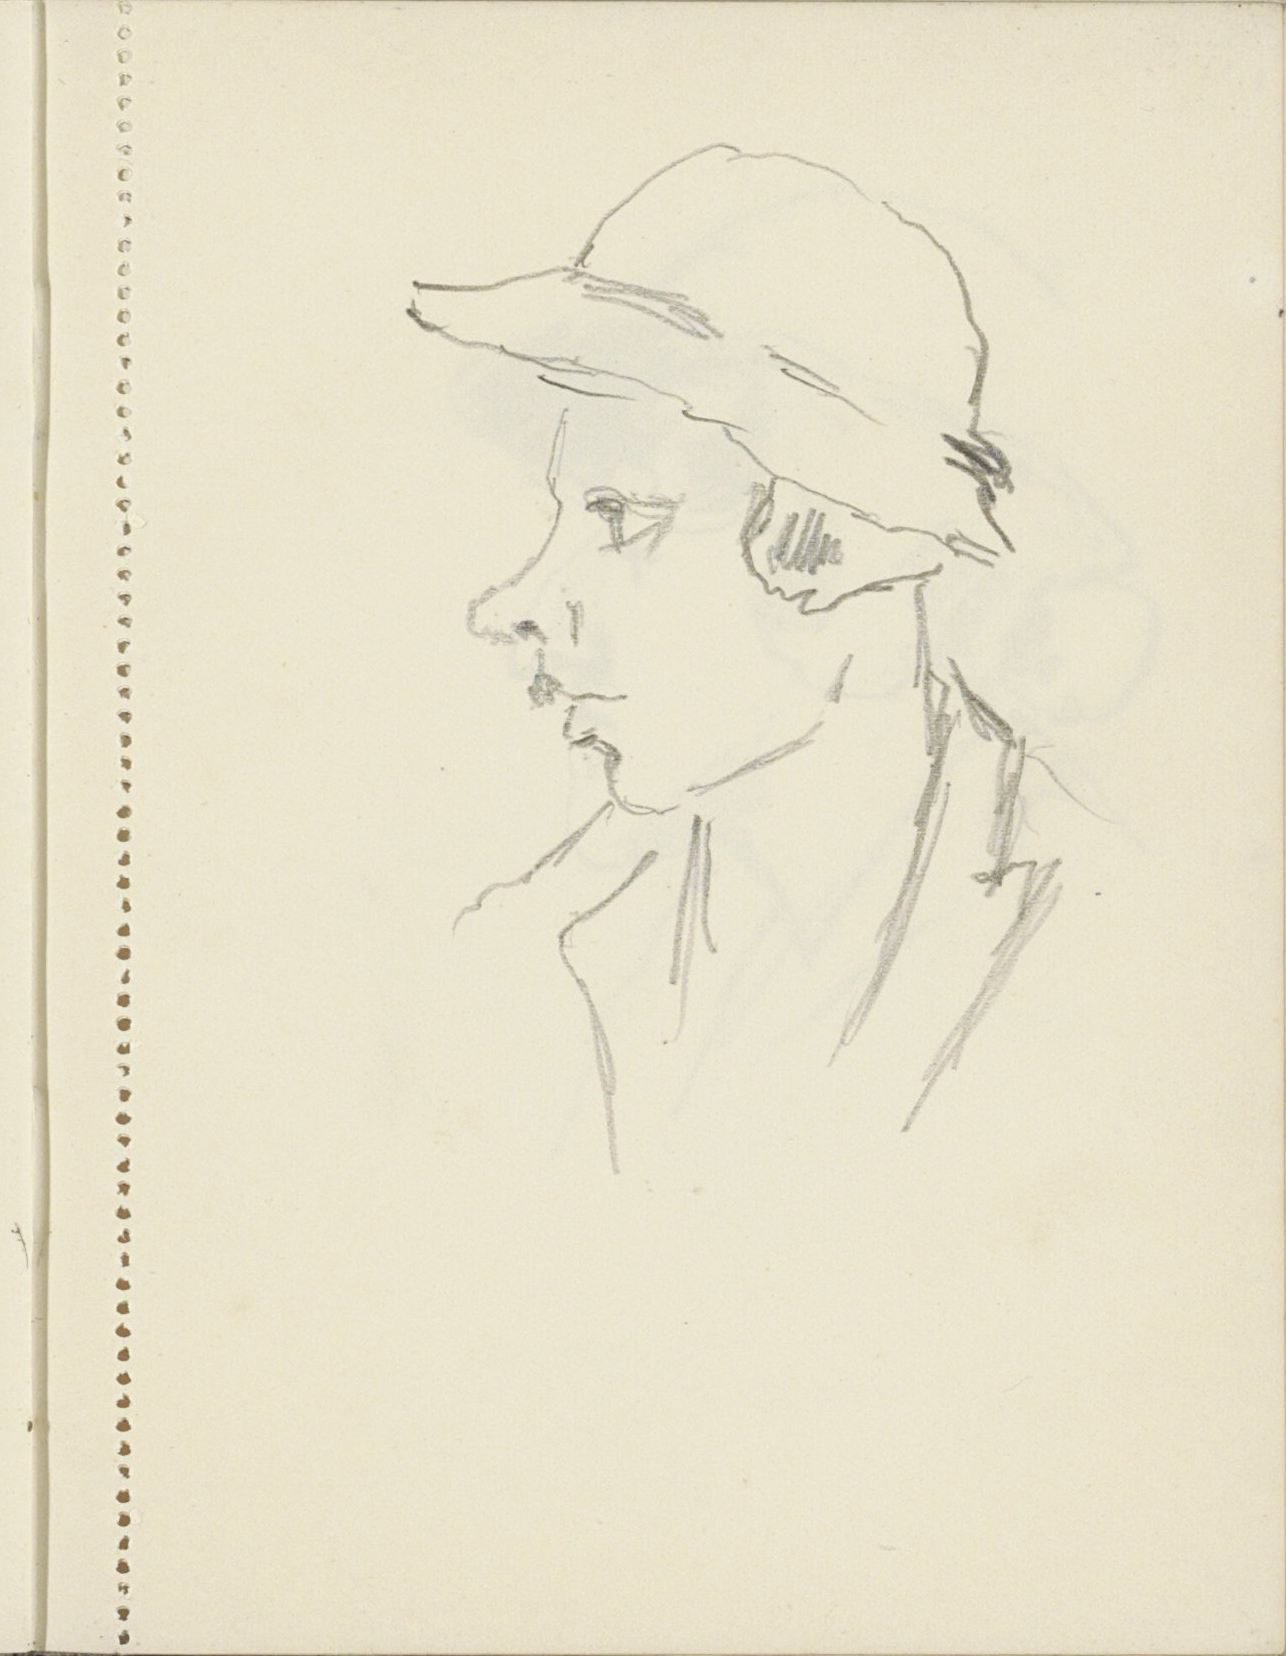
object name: sketchbook leaf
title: Kop van een vrouw met een hoed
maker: cornelis vreedenburgh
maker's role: draughtsman, print maker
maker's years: 1880-1946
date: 1890-1946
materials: paper, pencil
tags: head-gear: hat (+ women's clothes), head (human) - aa - female human figure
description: Blad 23 recto uit een schetsboek met 71 bladen.